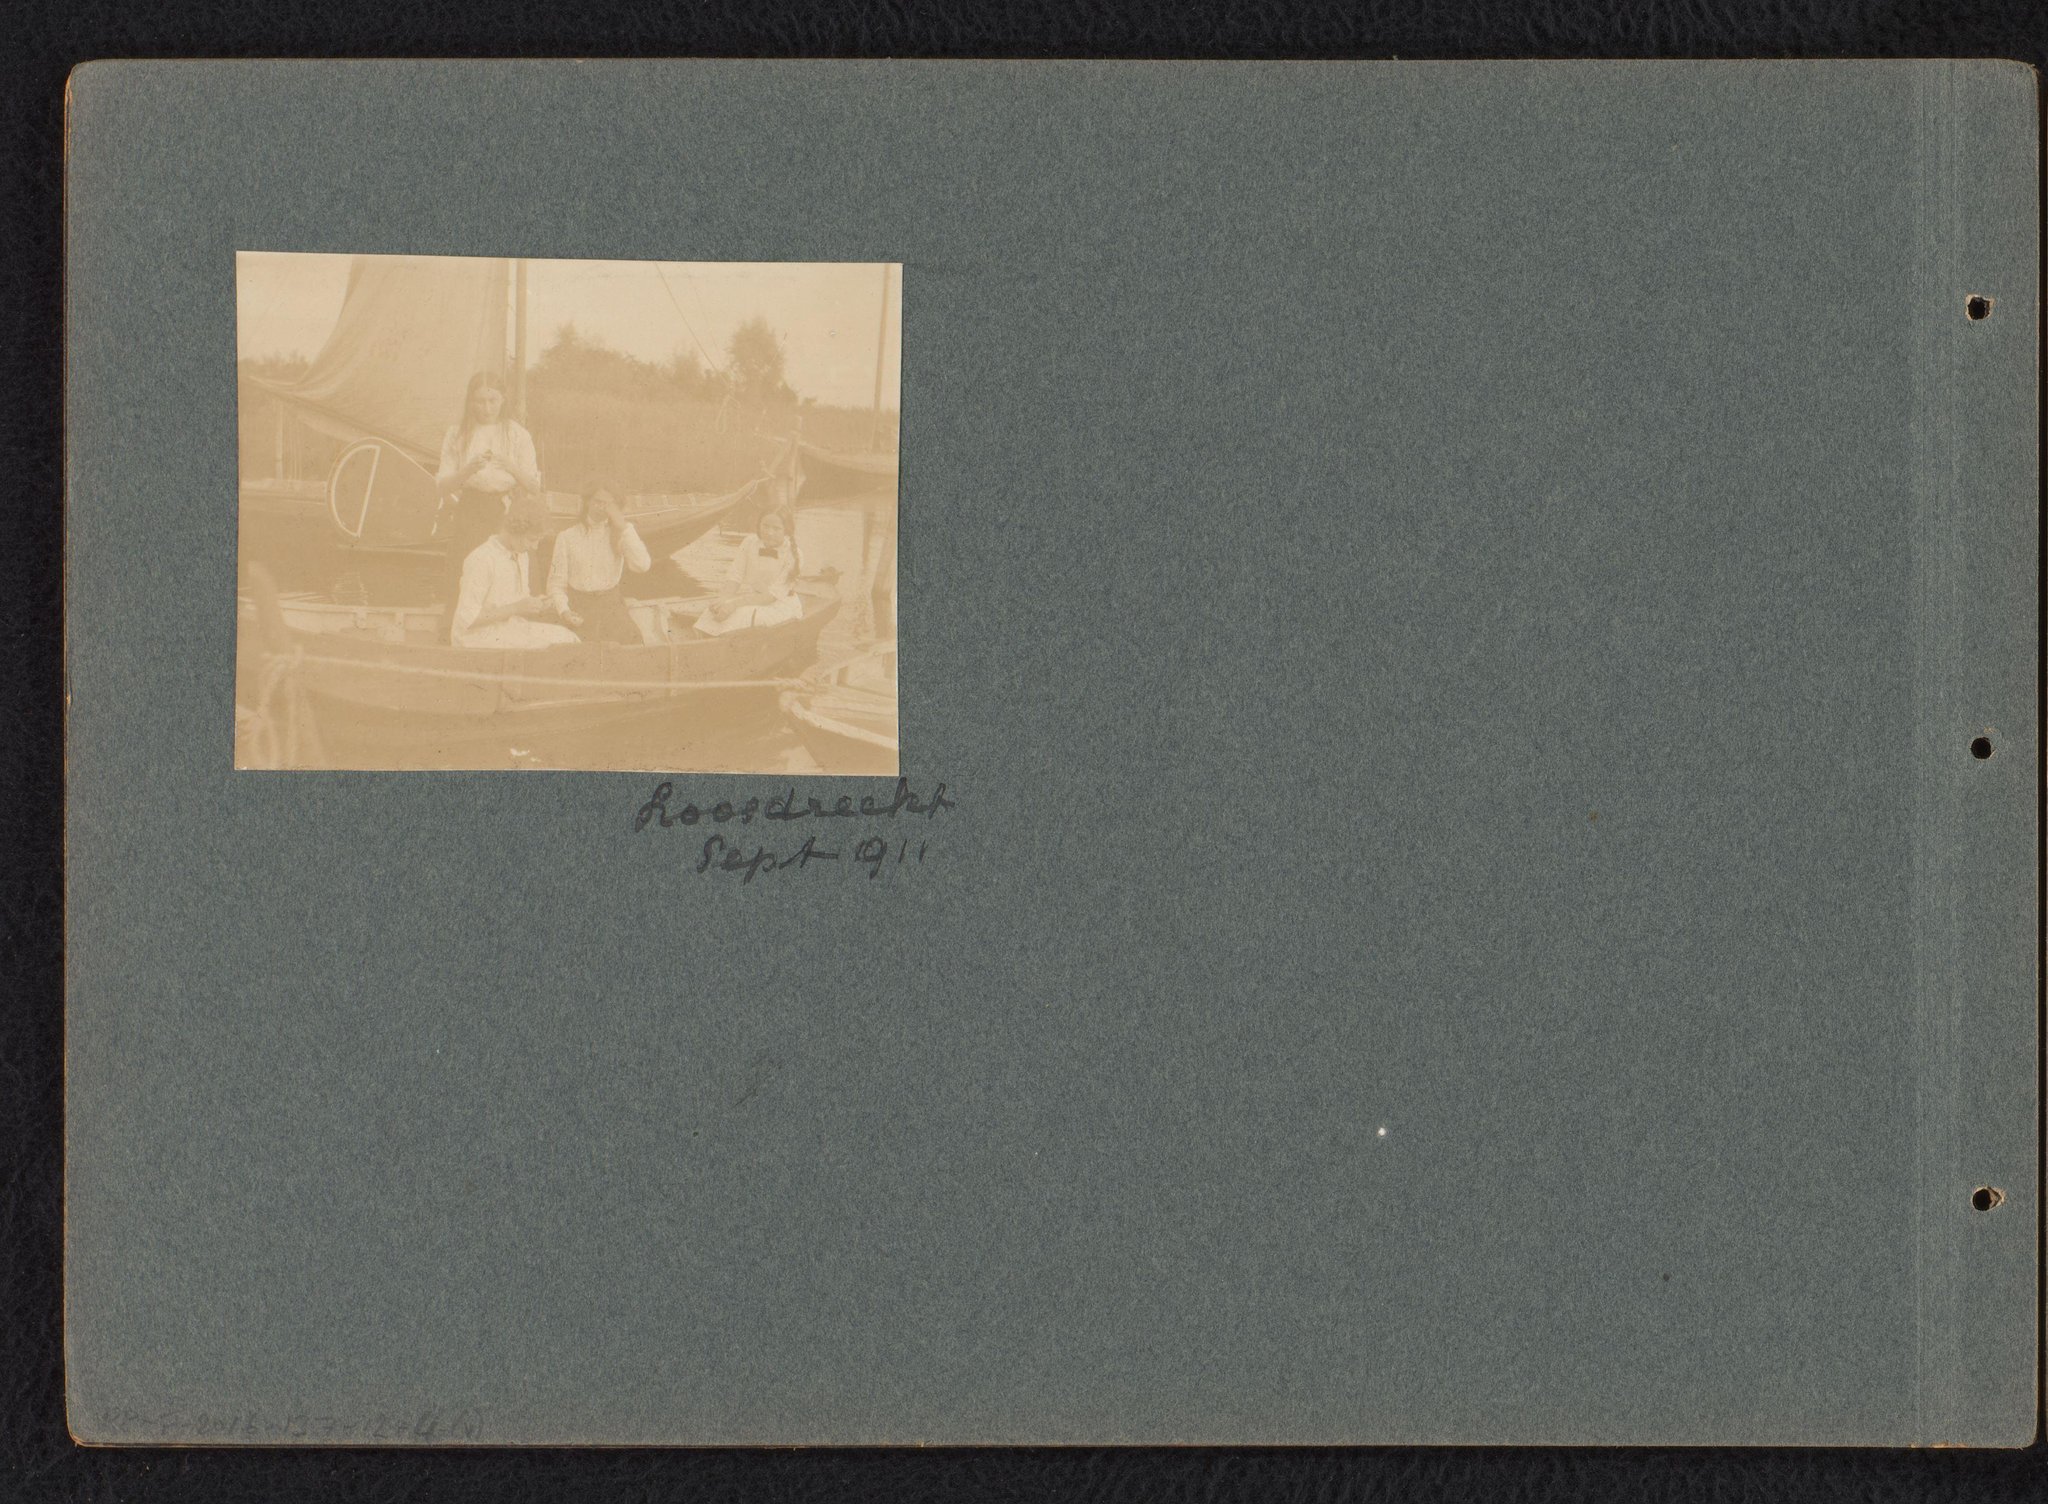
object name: photograph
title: Loentje en Willy Onnen met twee andere meisjes op een zeilboot in Loosdrecht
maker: carolina frederika onnen (lien/loen)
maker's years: 1896-1983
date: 1909-1911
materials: paper, cardboard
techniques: collodion silver print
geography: loosdrecht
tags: batavia, emilie albertina onnen (milly), amsterdam, carolina frederika onnen (lien/loen), sailing-ship, sailing-boat, historical persons - bb - woman, anonymous historical persons portrayed in a group, in a group-portrait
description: Deze foto's zijn onderdeel van een album.